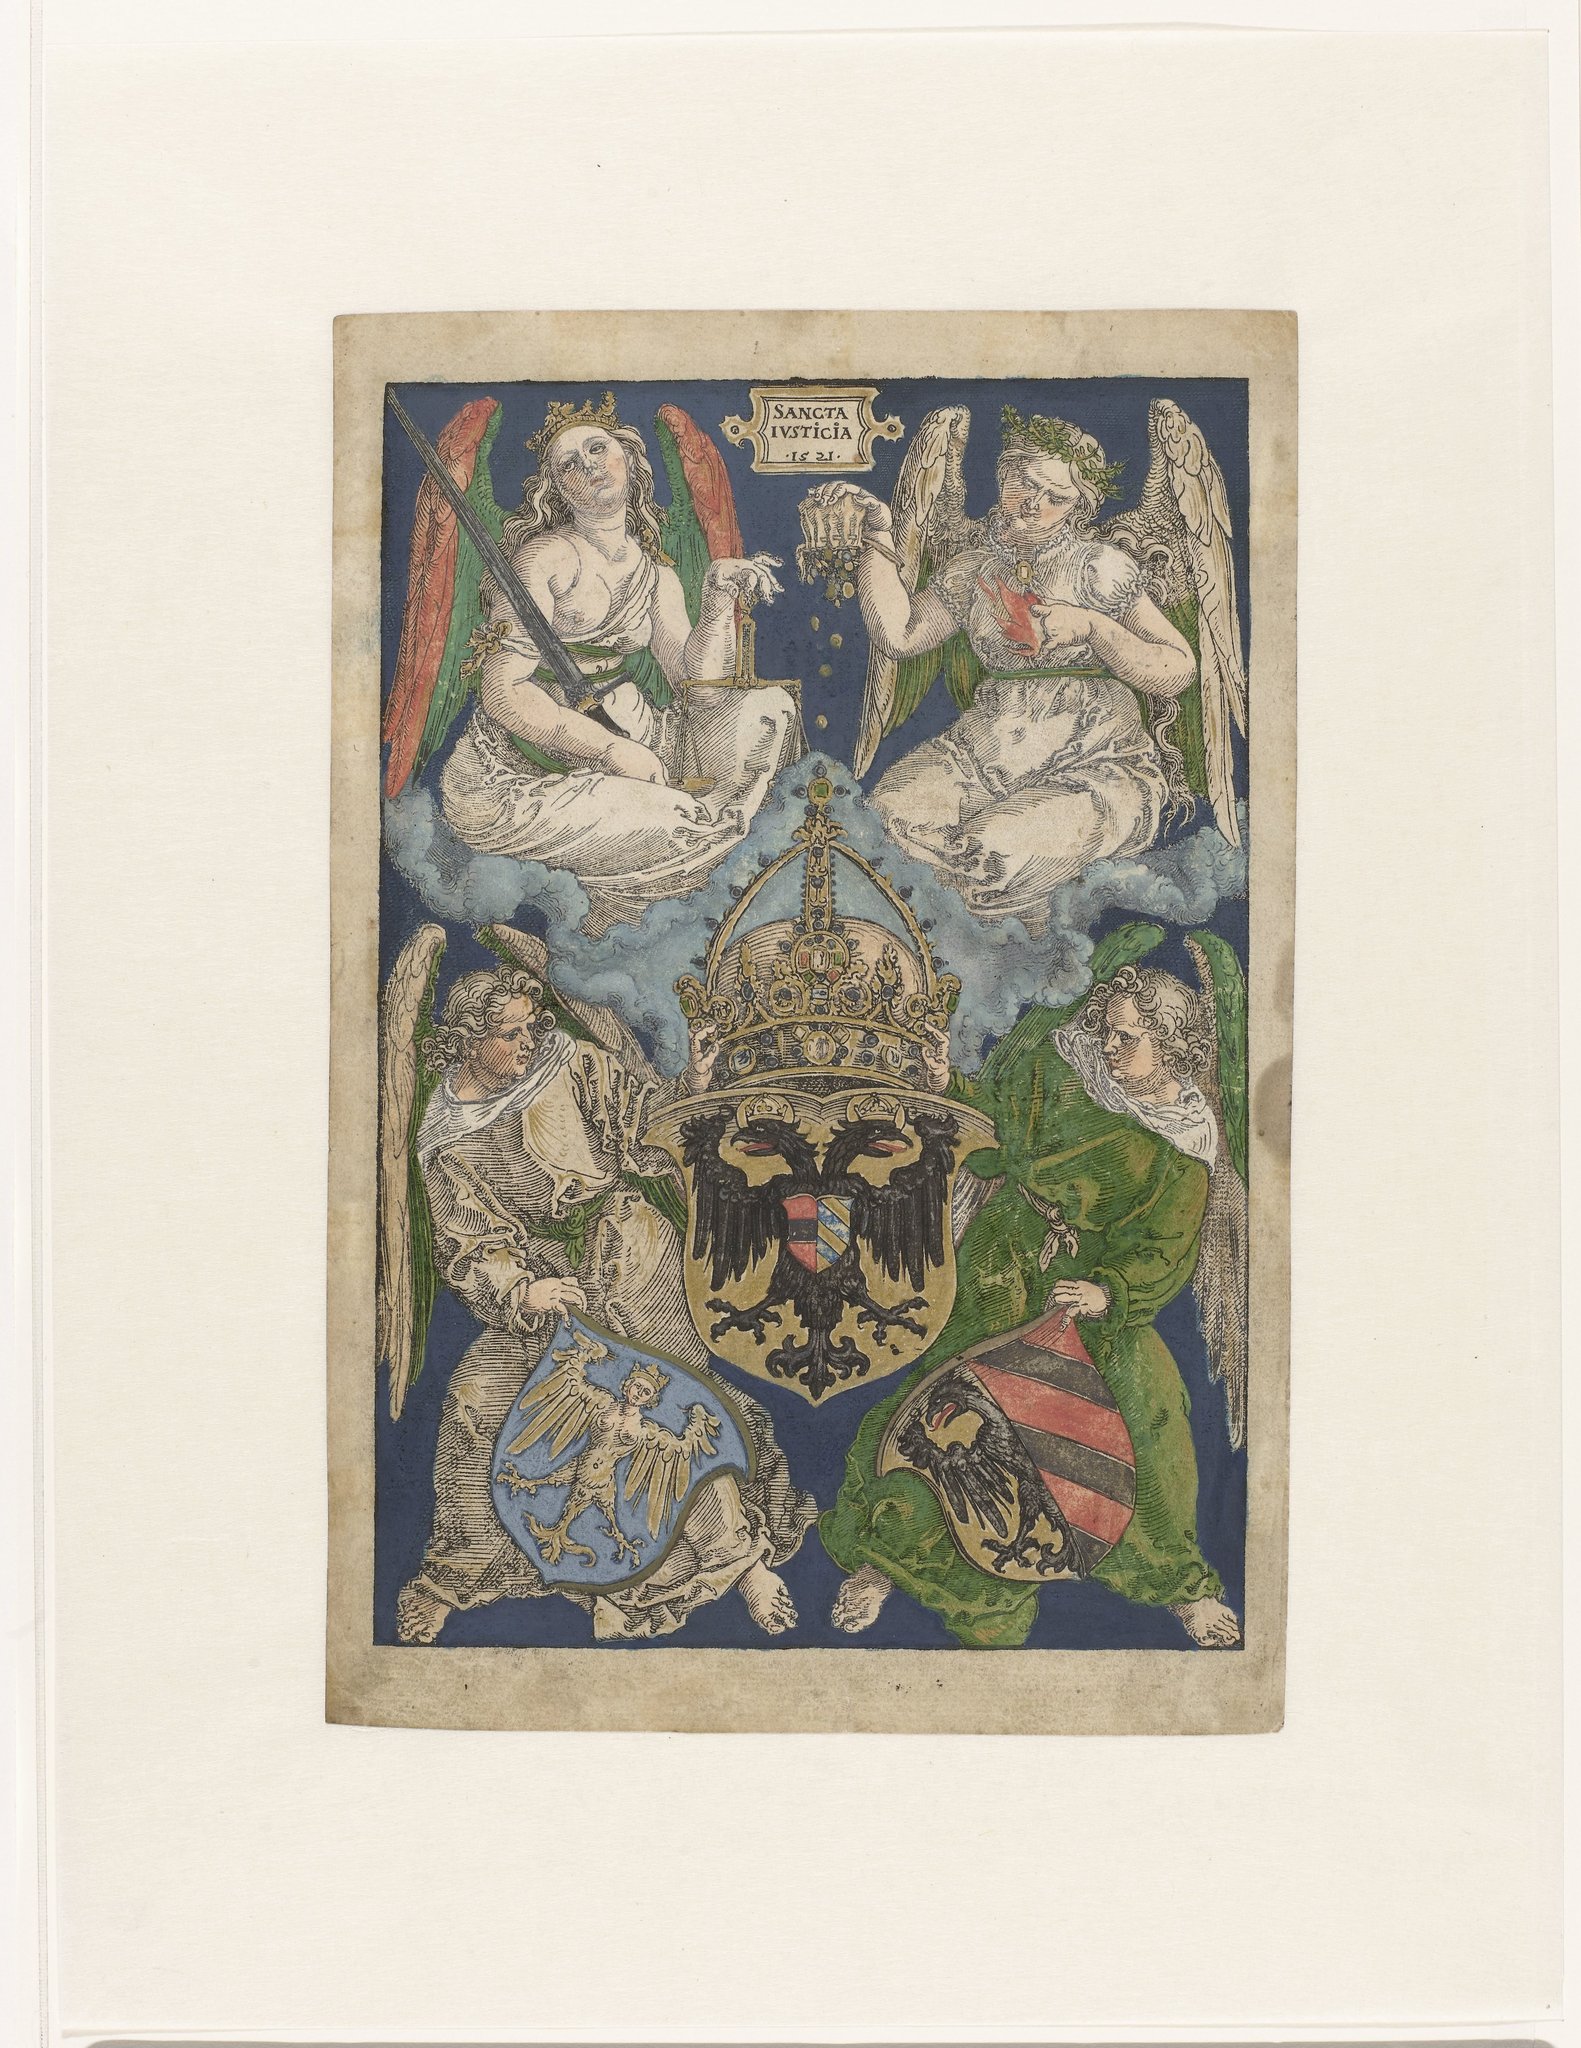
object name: print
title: Allegorie op het bestuur van de stad Neurenberg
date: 1521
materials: paper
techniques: hand coloring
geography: nuremberg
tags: double-headed eagle, purse, money-bag, justice, 'justitia'; 'giustitia divina' (ripa) ~ one of the four cardinal virtues, heart symbolism, abundance; 'abondanza', 'abondanza maritima' (ripa), angels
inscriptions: date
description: Verso van titelblad boek 'Reformacion der Stat Nüremberg / Cum Gratia et Privilegio'. Twee engelen houden drie schilden op, twee met de stadswapens van Neurenberg en één met het keizerlijke wapen. Daarboven op wolken de personificaties van Justitia en Liberalitas of Abundantia, die een buidel leegschudt.